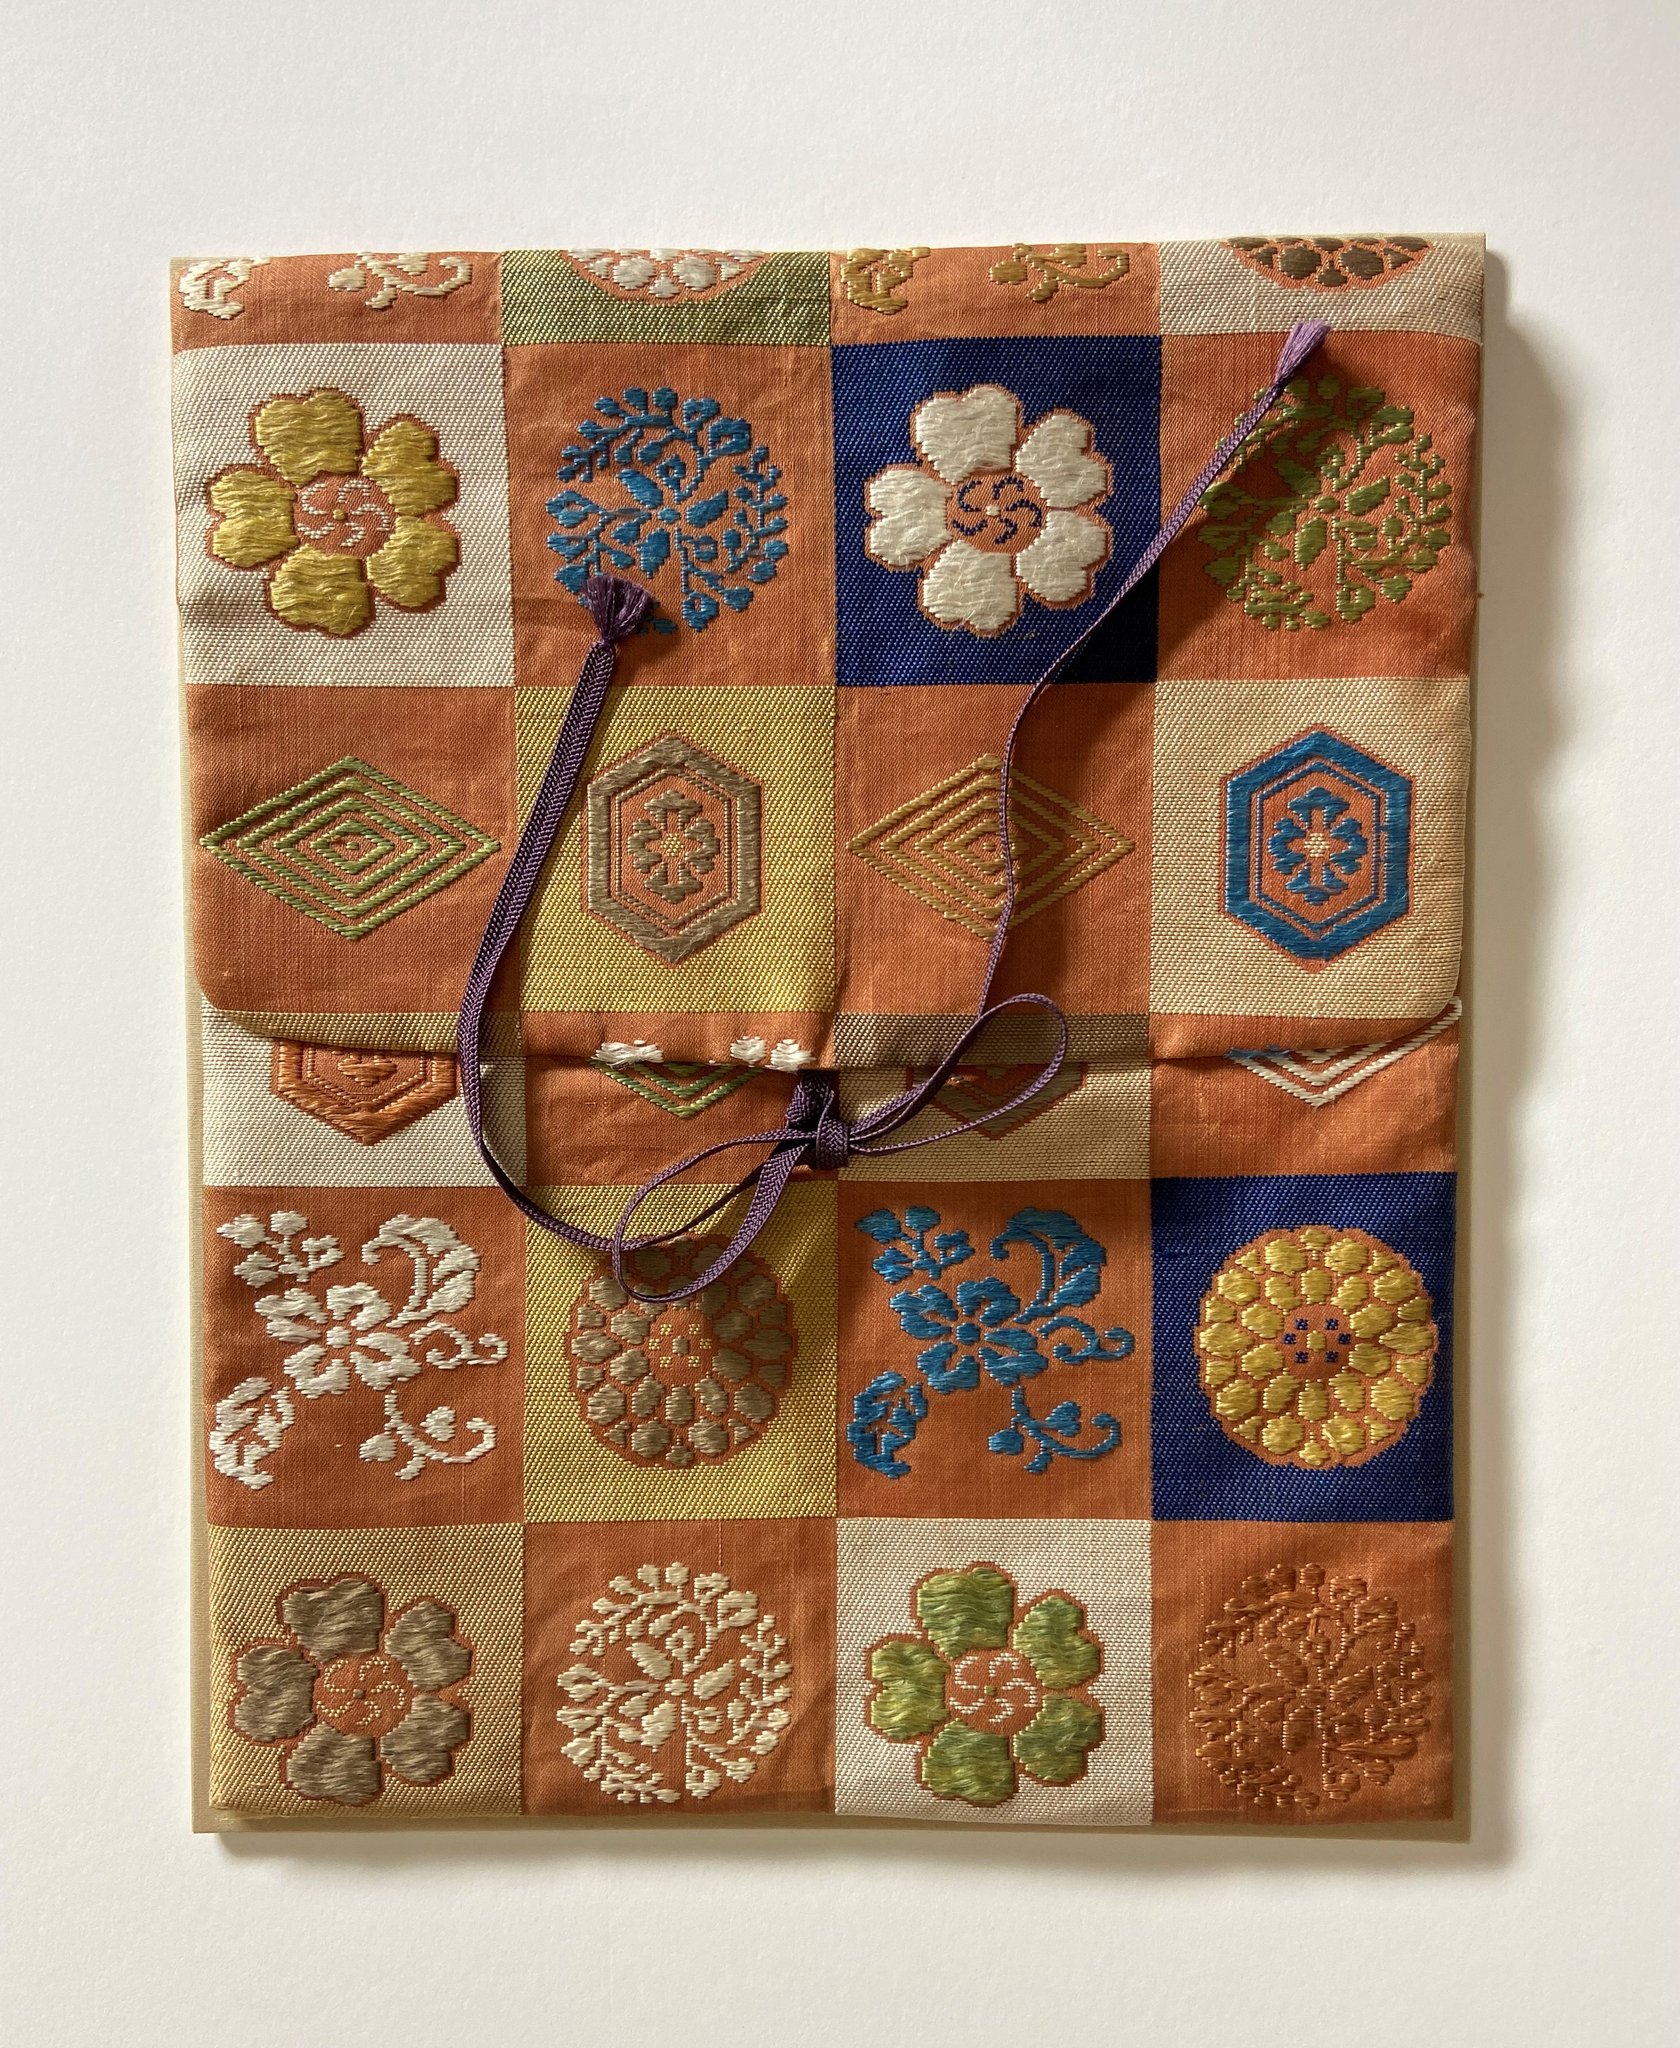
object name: bag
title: Bag for a Noh Mask with Flowers and Geometric Patterns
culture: japanese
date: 1801-1850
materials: silk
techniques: patterning, weave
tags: flowers